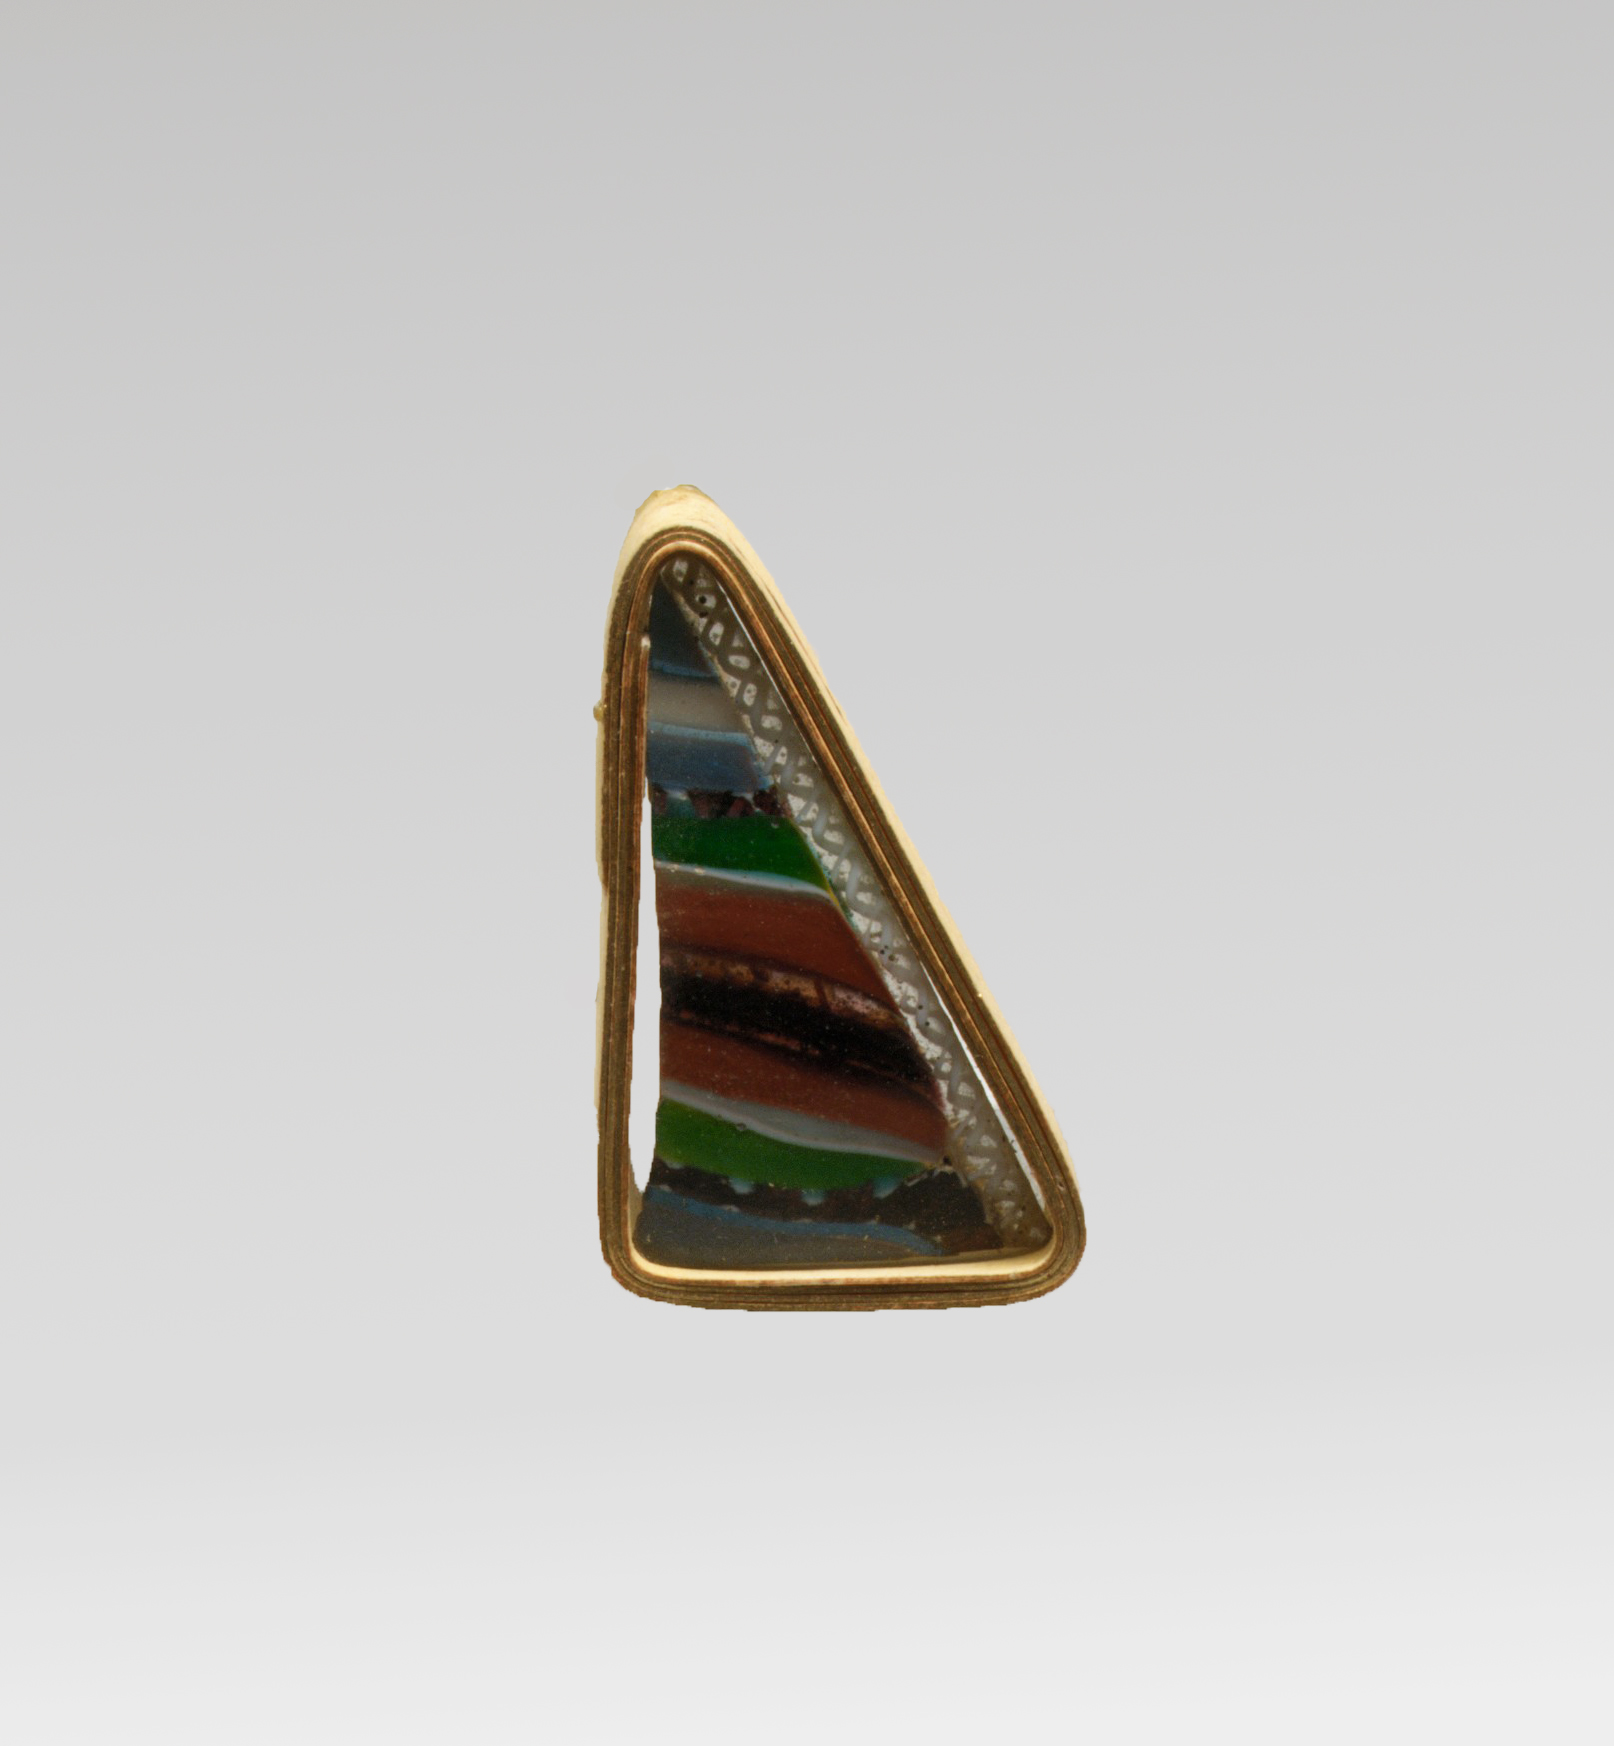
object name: fragment, striped mosaic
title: Glass striped mosaic bowl fragment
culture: roman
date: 34 BCE-33 CE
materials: glass